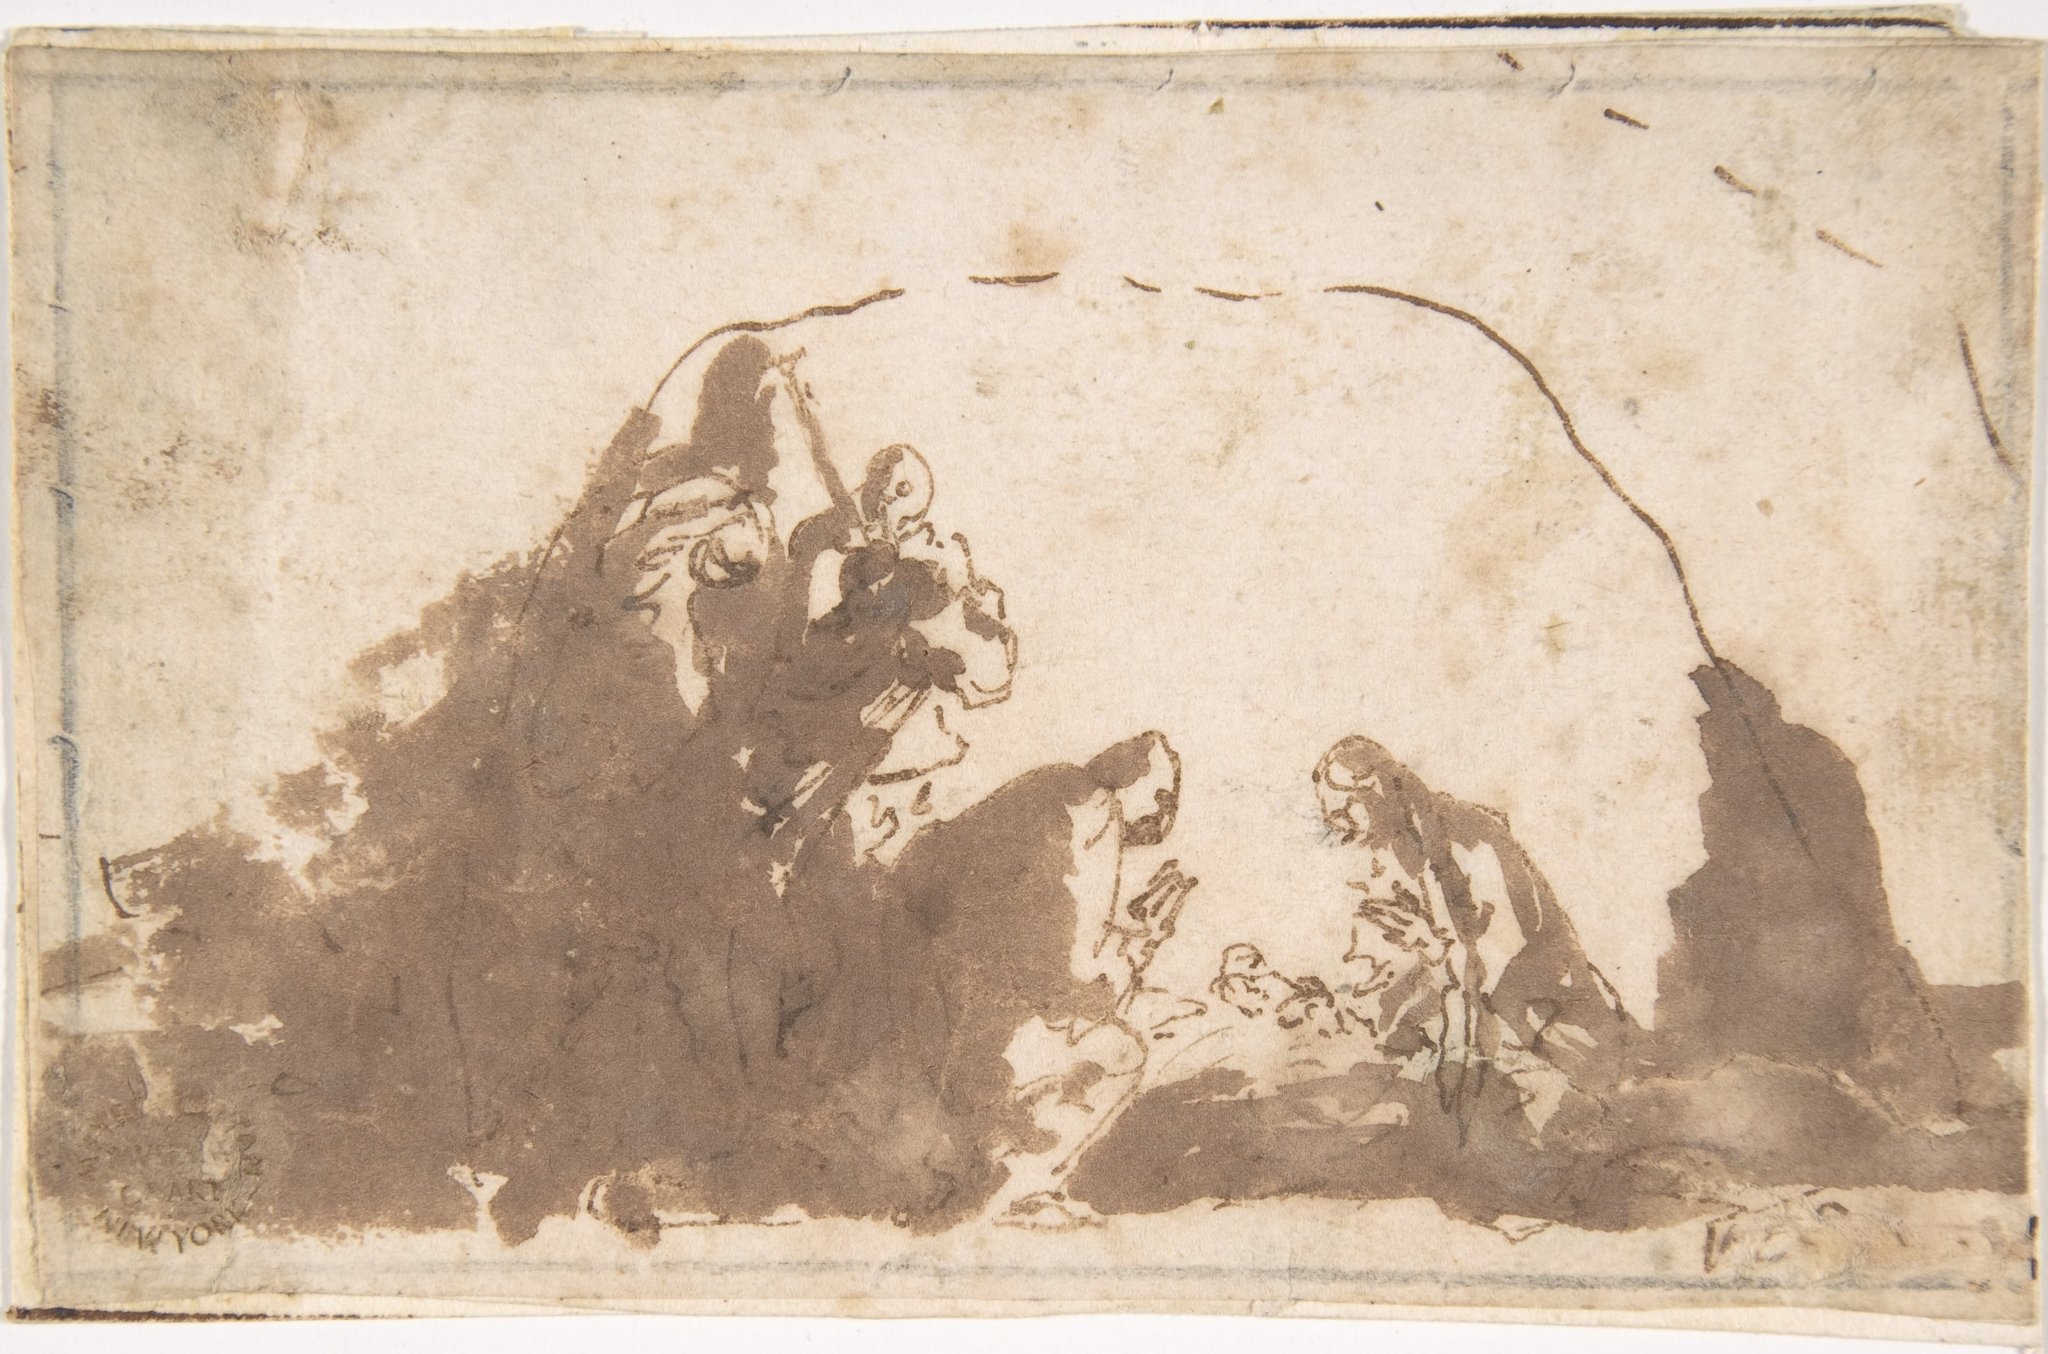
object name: drawing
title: Adoration of the Magi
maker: anonymous, dutch, 17th century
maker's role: artist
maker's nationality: dutch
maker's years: 1600-1700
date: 1601-1700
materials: chalk, ink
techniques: brush, pen, wash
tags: adoration of the magi